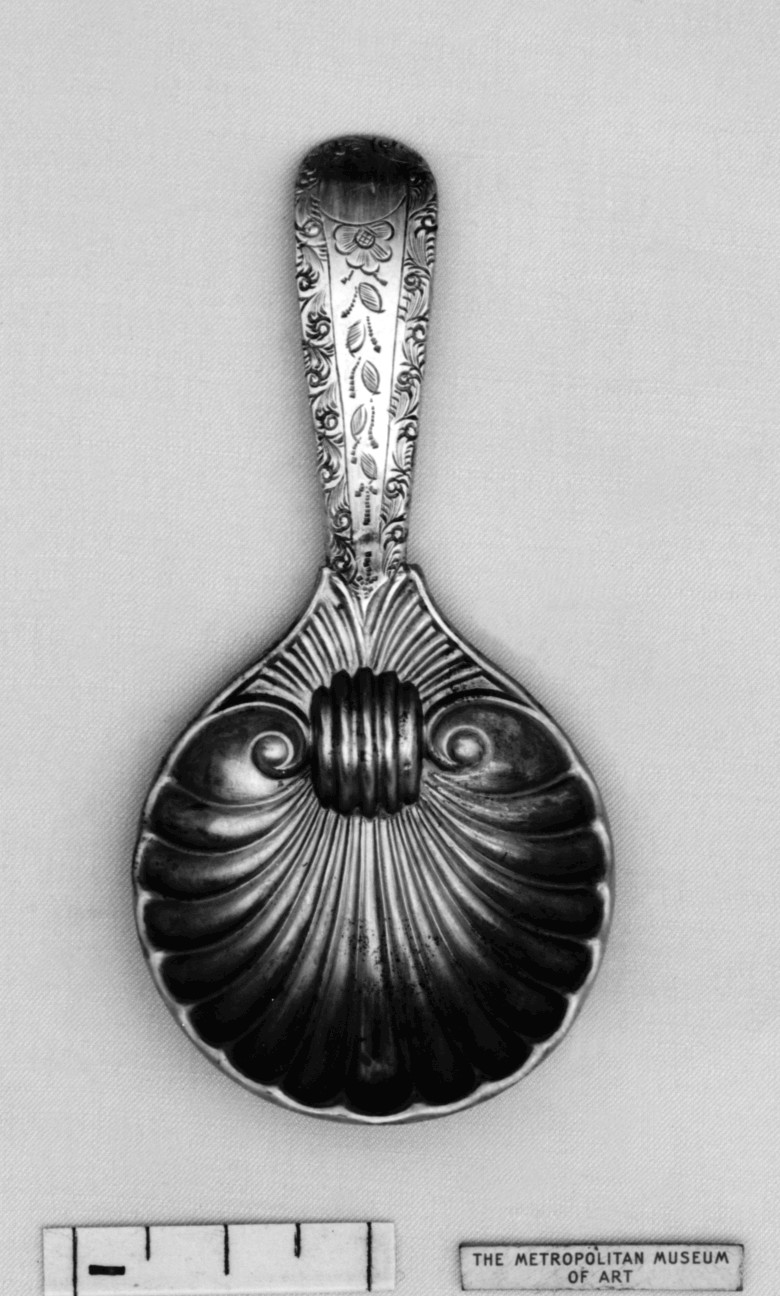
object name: caddy spoon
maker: william fearn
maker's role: maker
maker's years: 1769-1824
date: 1794-1795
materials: gilt, silver